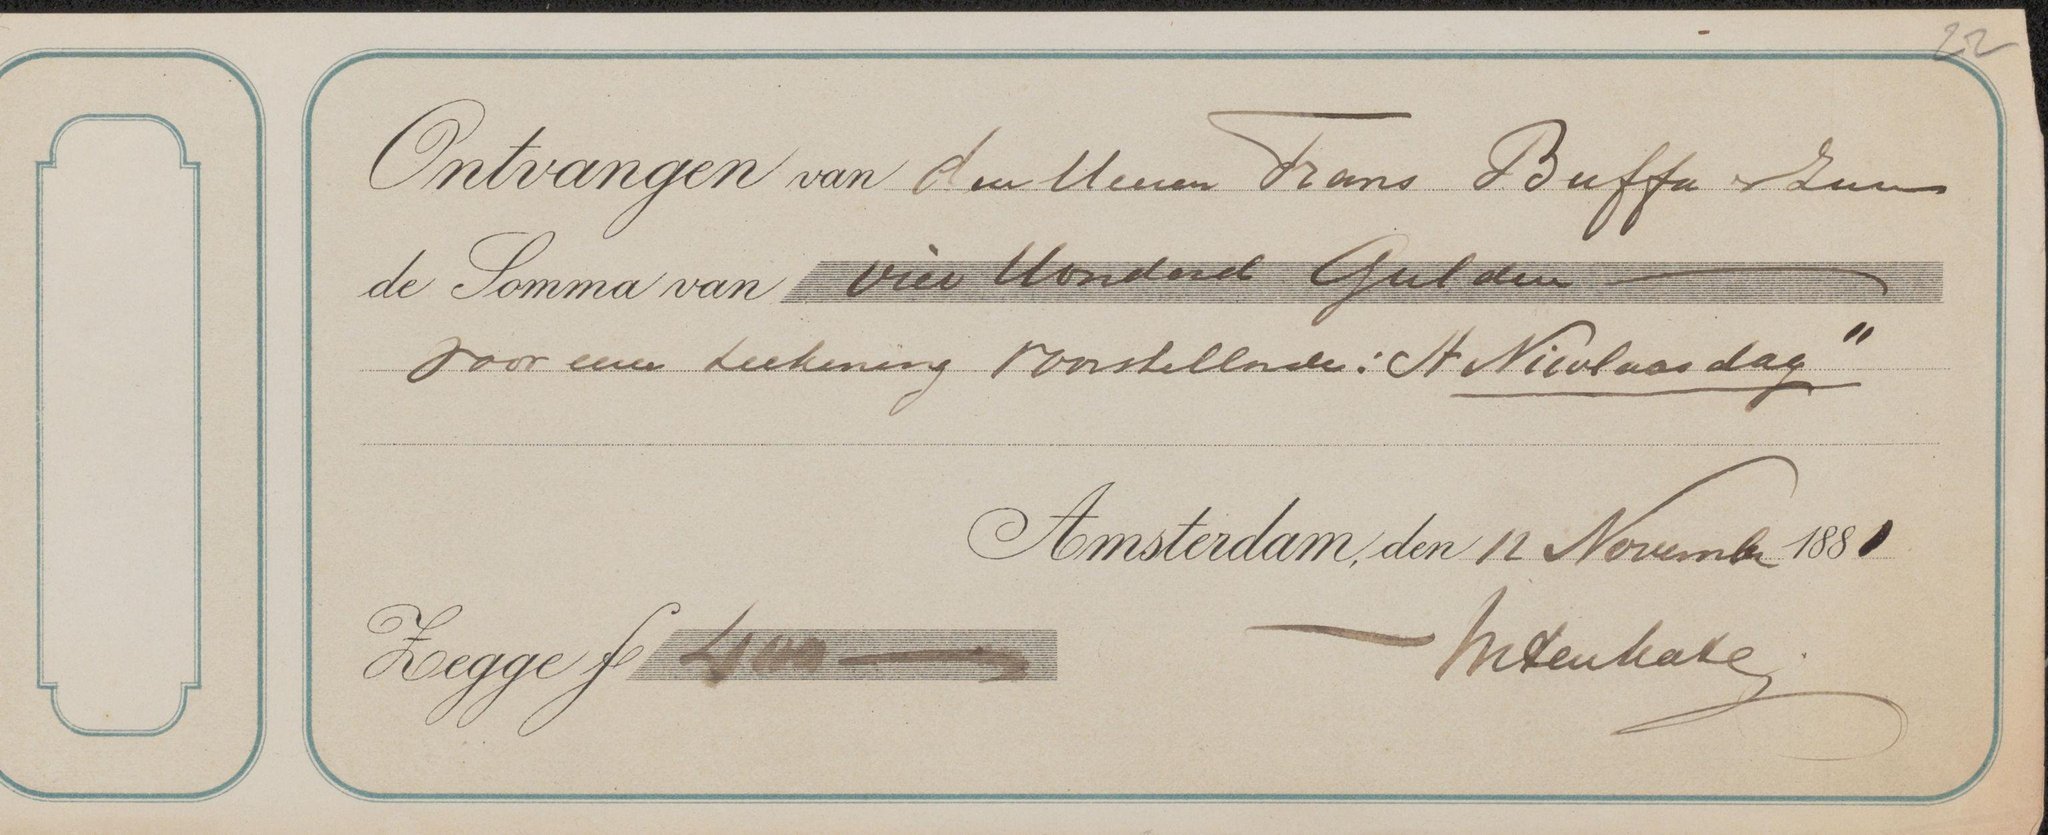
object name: ontvangstbewijs, kwitantie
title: Kwitantie voor Mari ten Kate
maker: mari ten kate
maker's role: draughtsman, painter, print maker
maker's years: 1831-1910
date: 1881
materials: ink, paper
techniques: pen, printing, writing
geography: amsterdam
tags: drawing, money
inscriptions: collector's mark: Lugt 2233